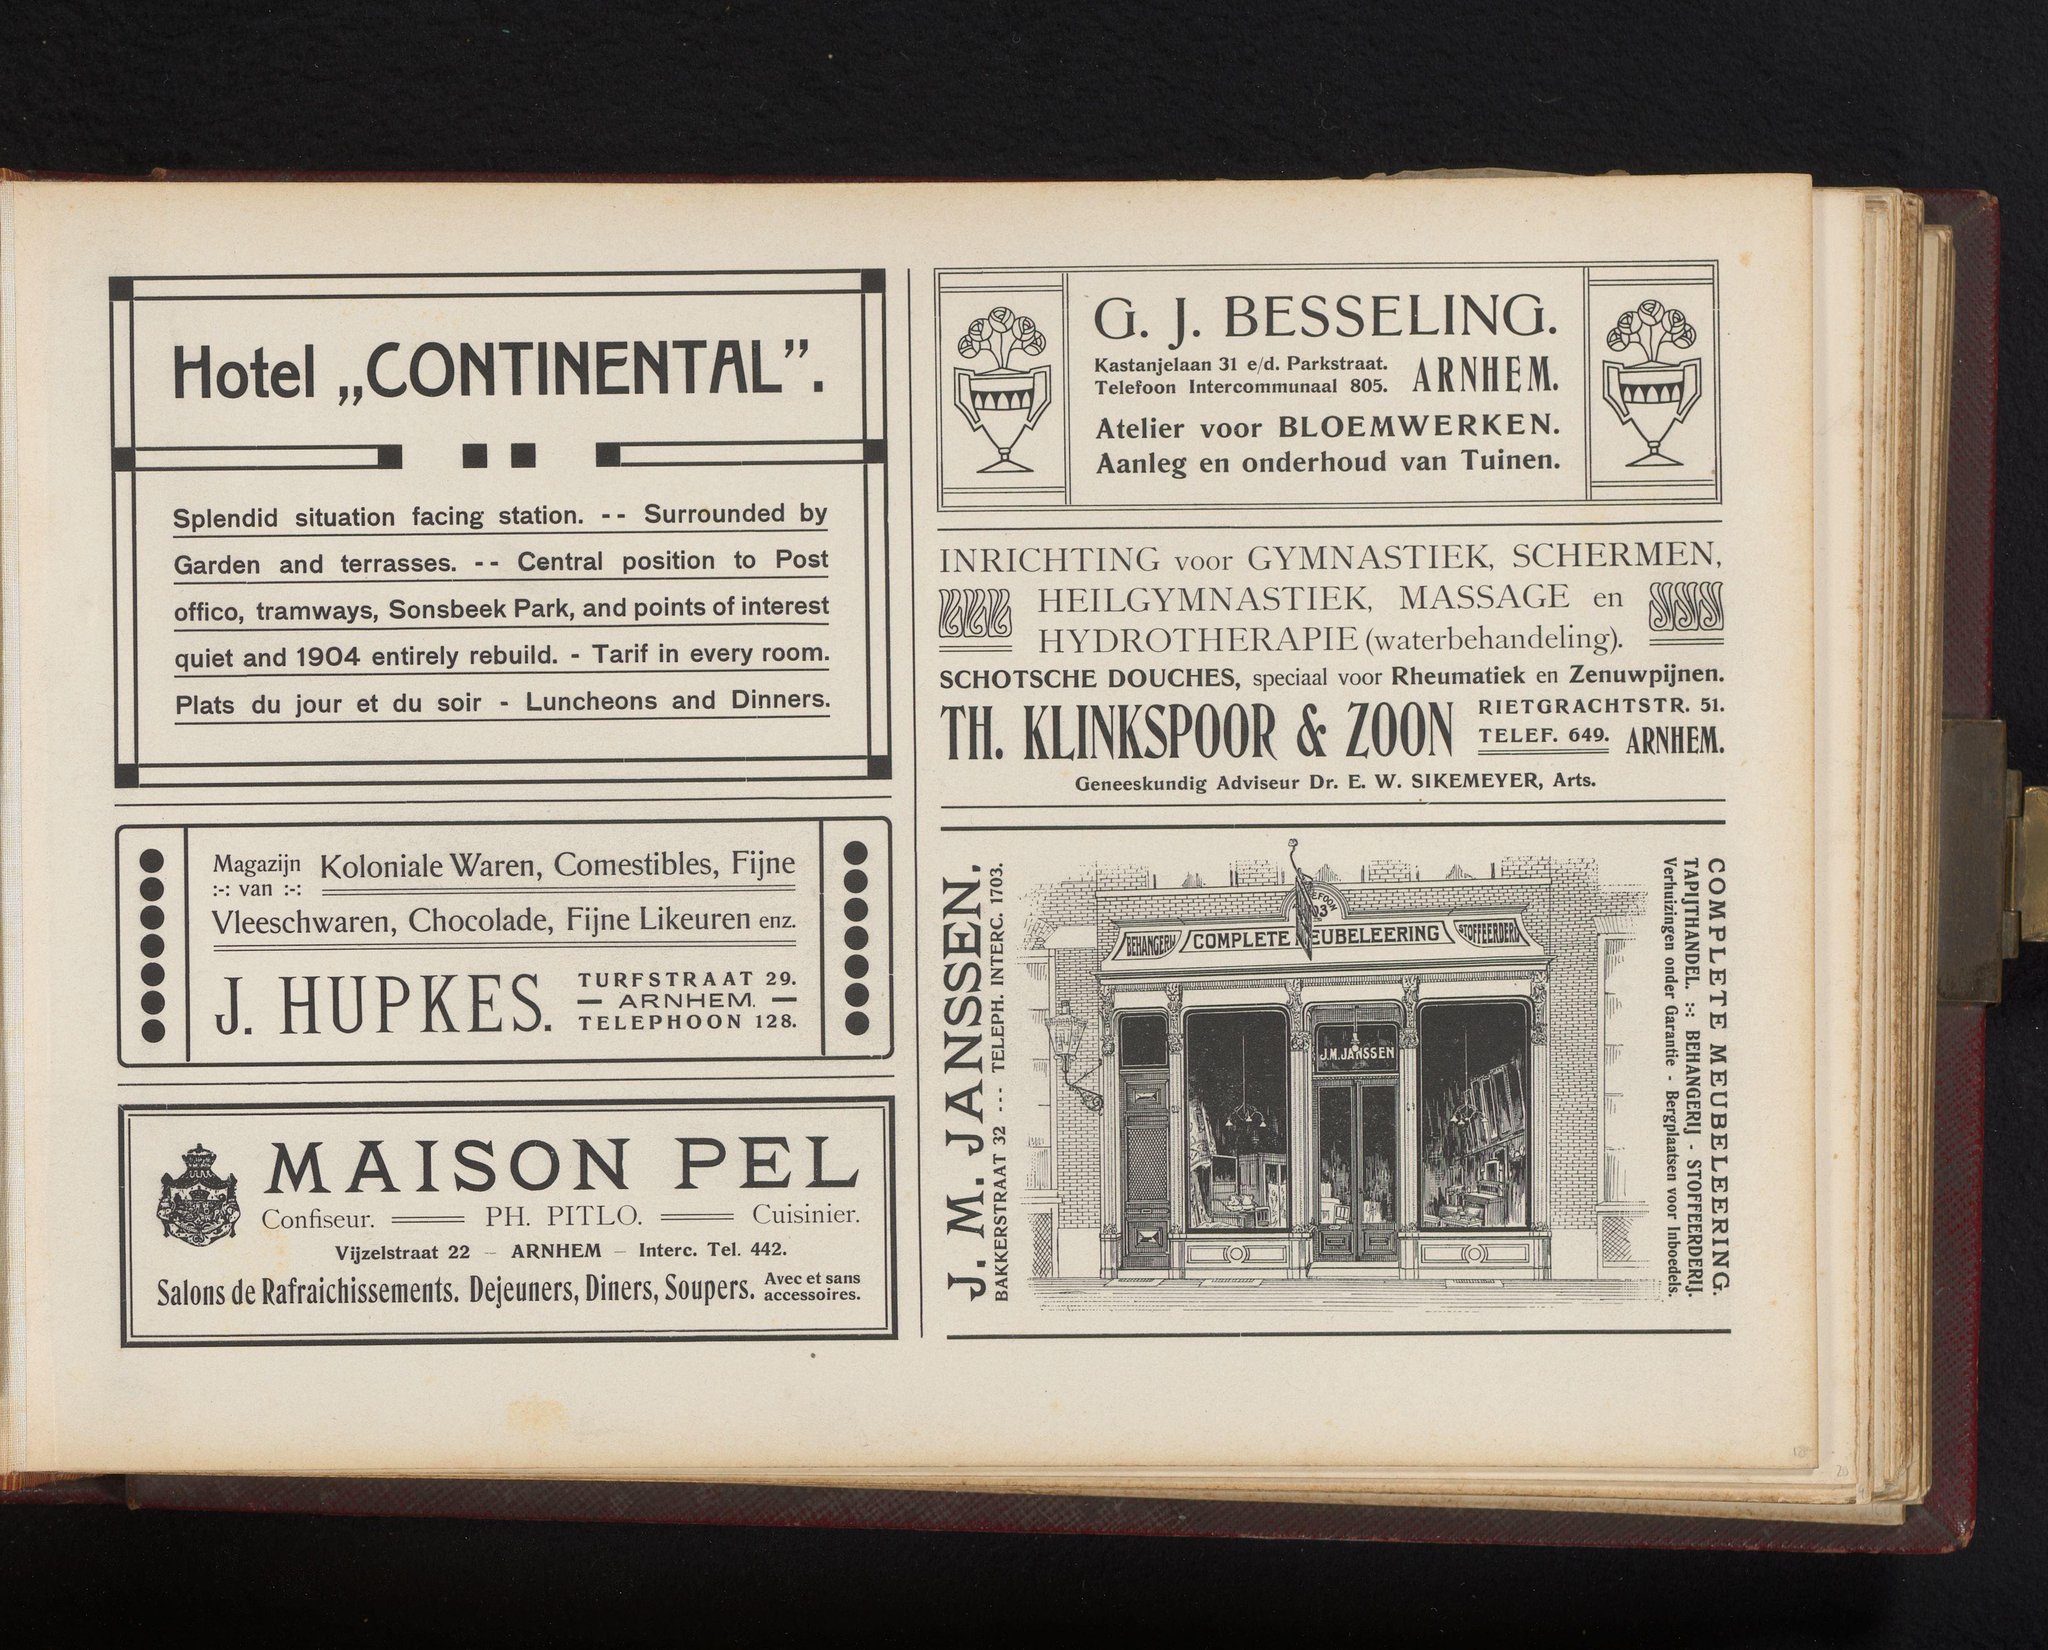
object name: album leaf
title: Advertenties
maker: Anonymous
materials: paper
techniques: printing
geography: netherlands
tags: advertising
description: Advertenties voor onder andere Hotel Continental, G.J. Besseling, J. Hupkes, Maison Pel en J.M. Janssen. Deze pagina maakt deel uit van een album.